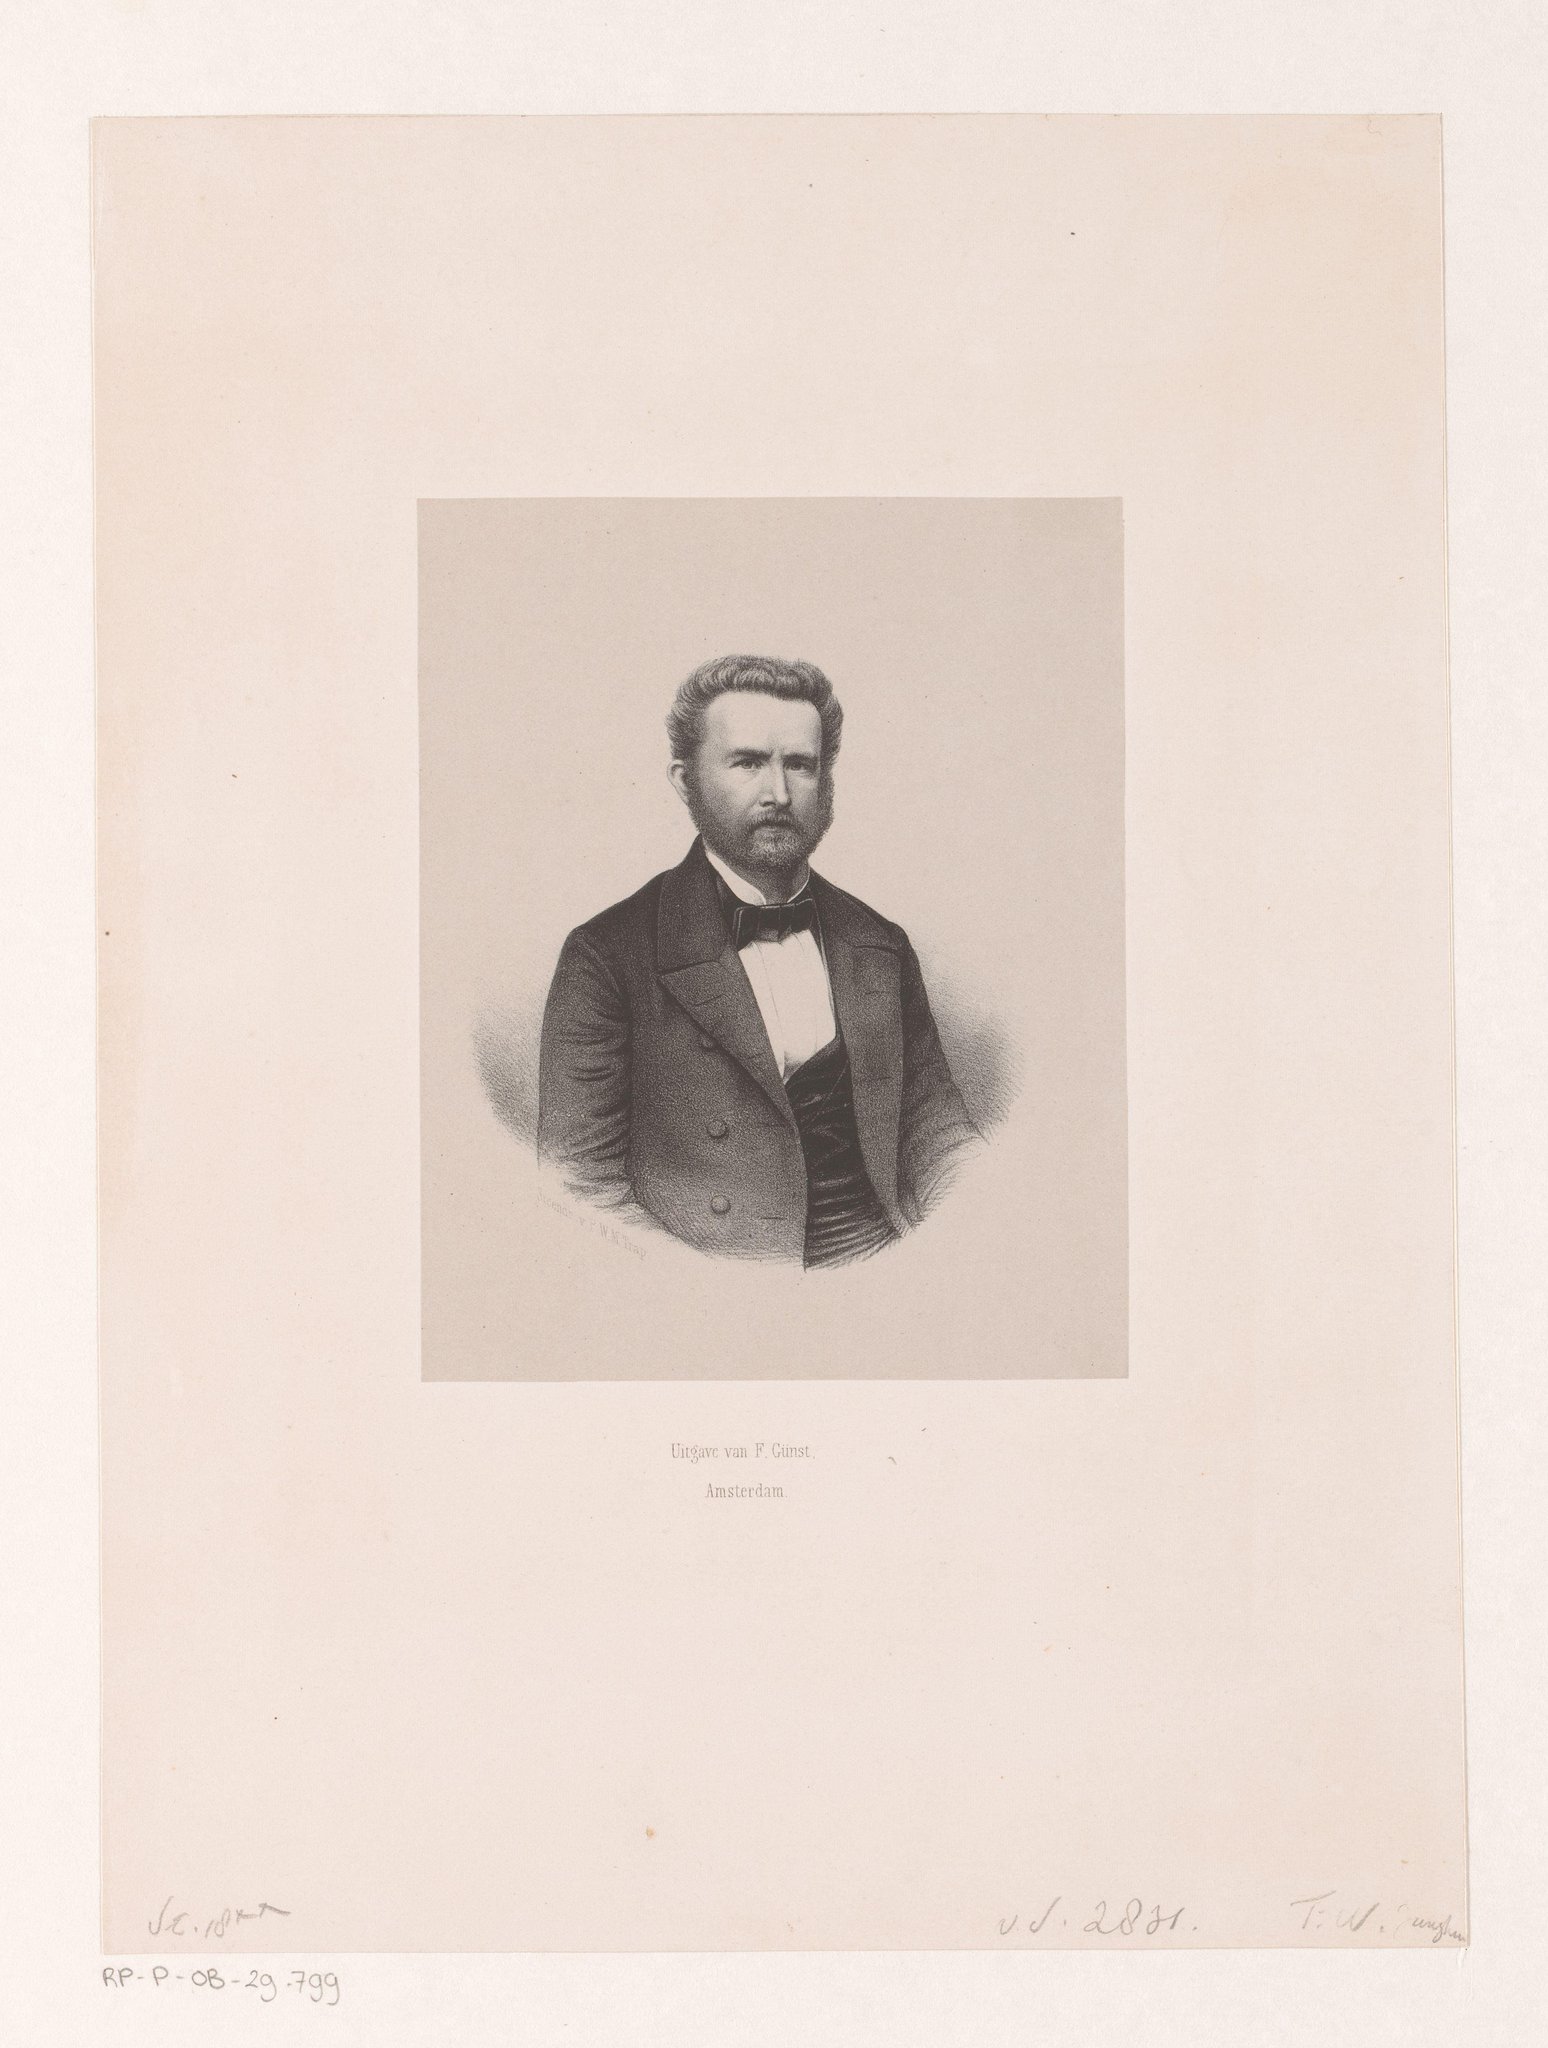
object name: print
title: Portret van Franz Junghuhn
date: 1866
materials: paper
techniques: lithograph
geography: amsterdam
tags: historical persons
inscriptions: collector's mark: Lugt 2228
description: Prent uit: Junghuhn, Franz. Licht- und Schattenbilder aus dem Innern von Java. Amsterdam: Günst, F., 1866.